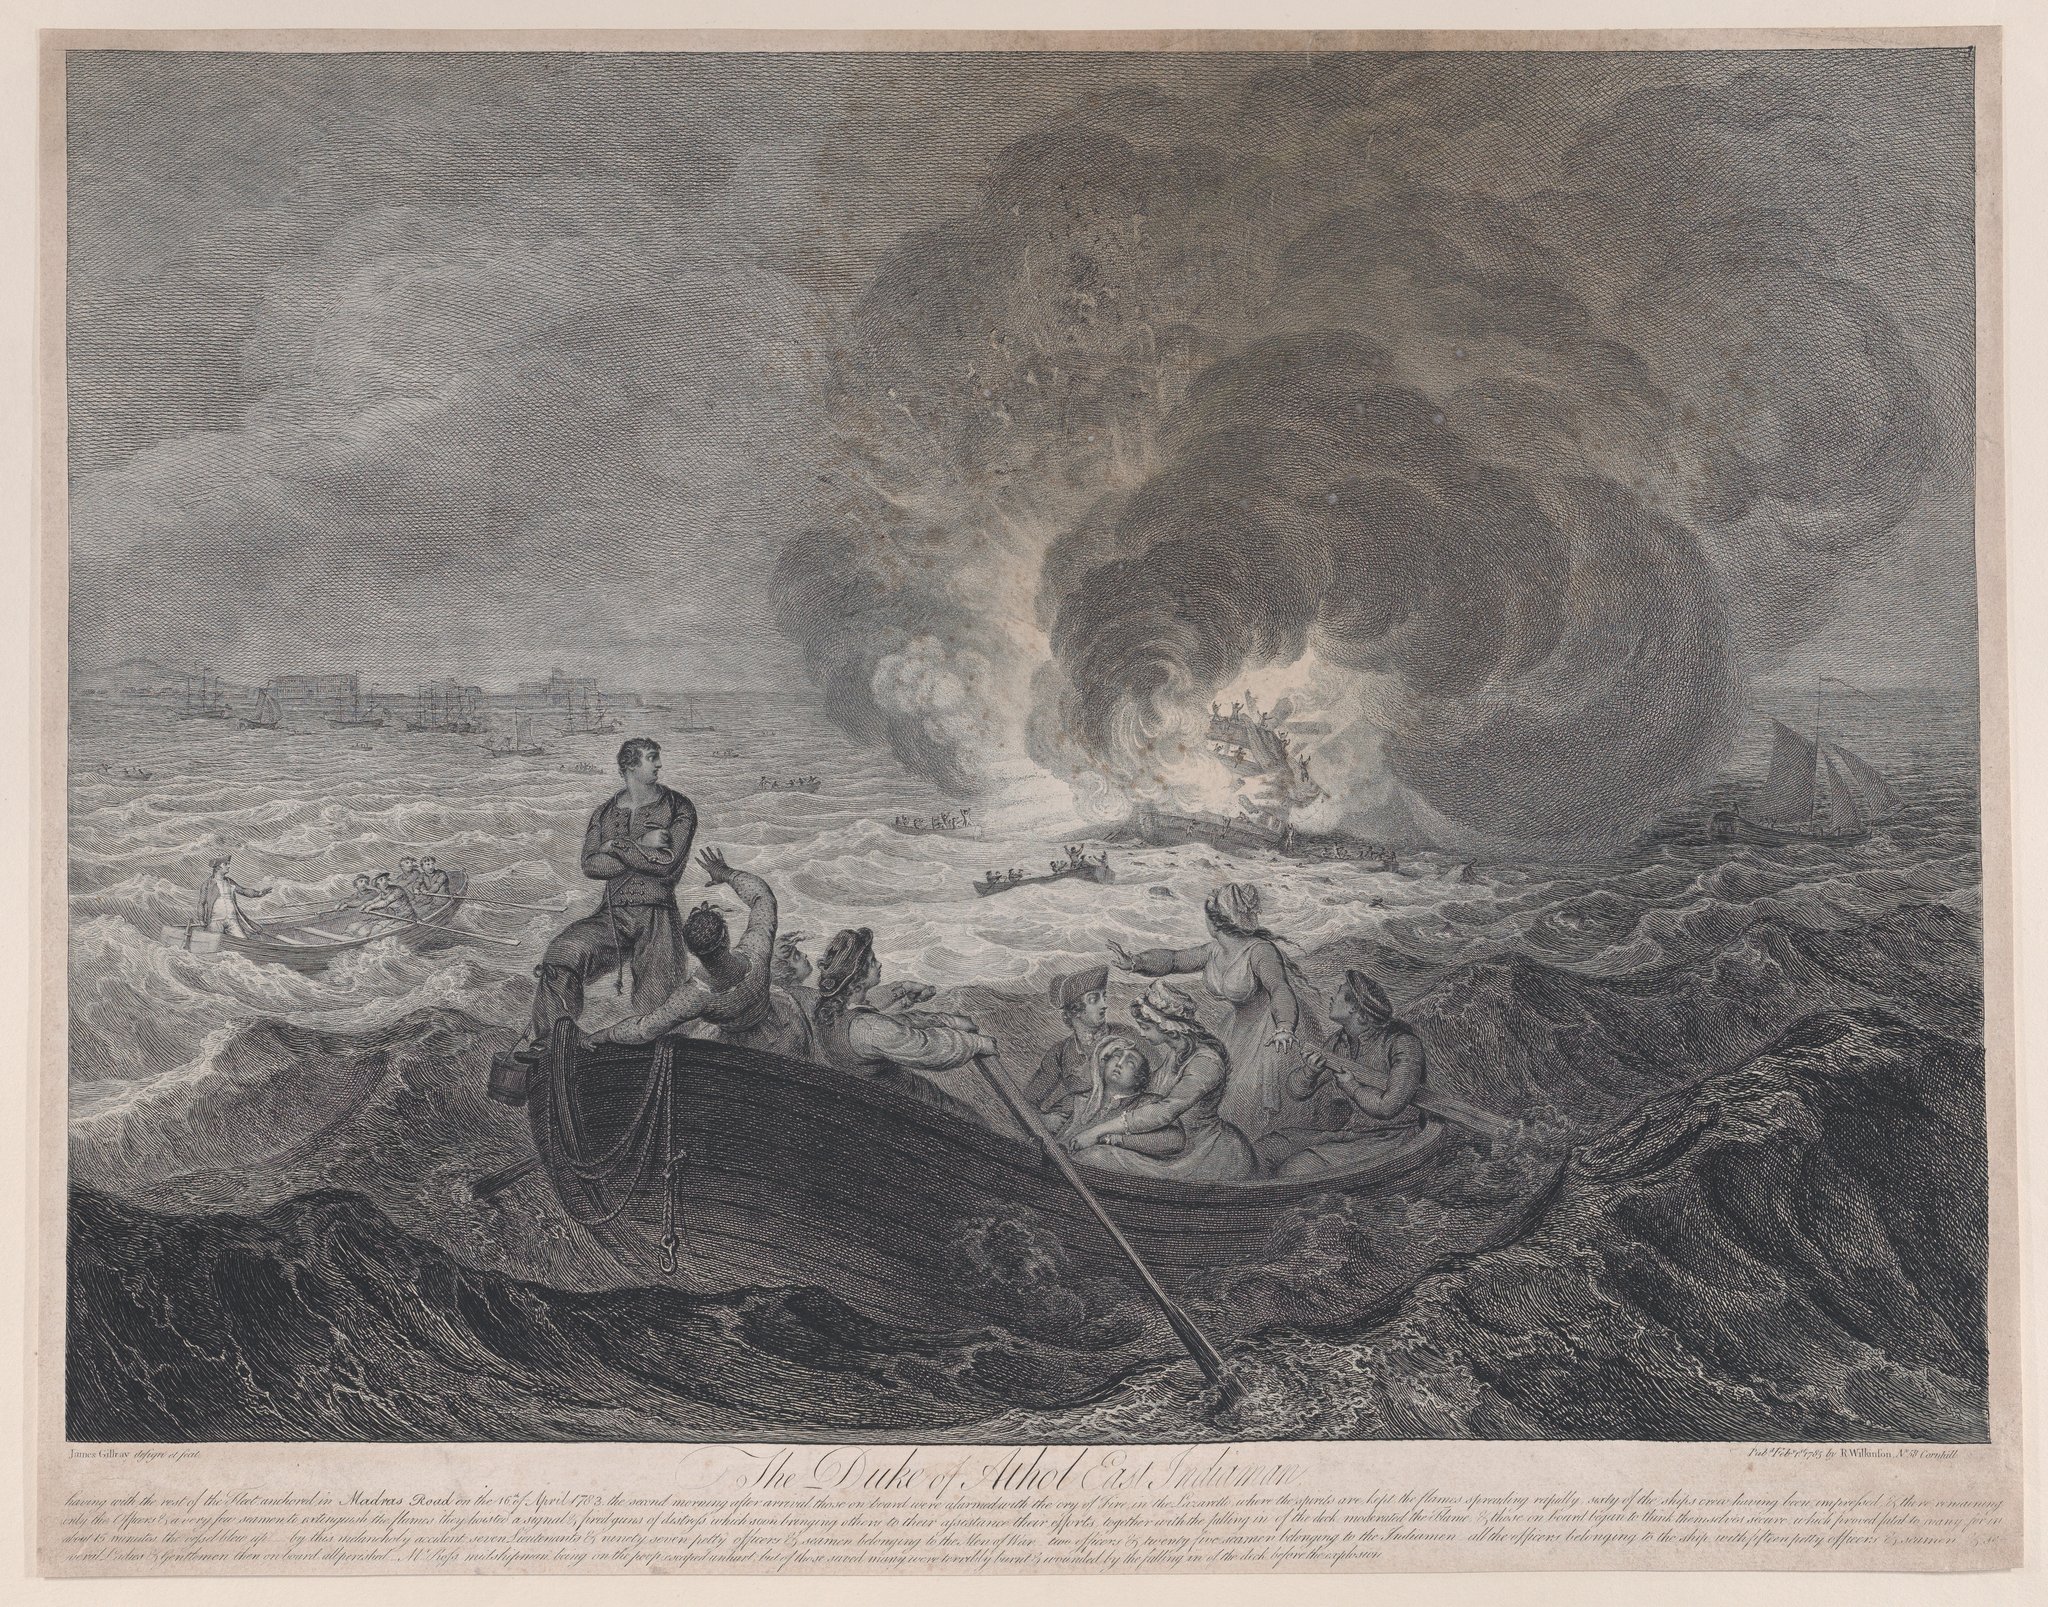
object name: print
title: The Duke of Athol, East Indiaman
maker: james gillray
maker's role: artist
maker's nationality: british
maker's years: 1756-1815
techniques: engraving, etching